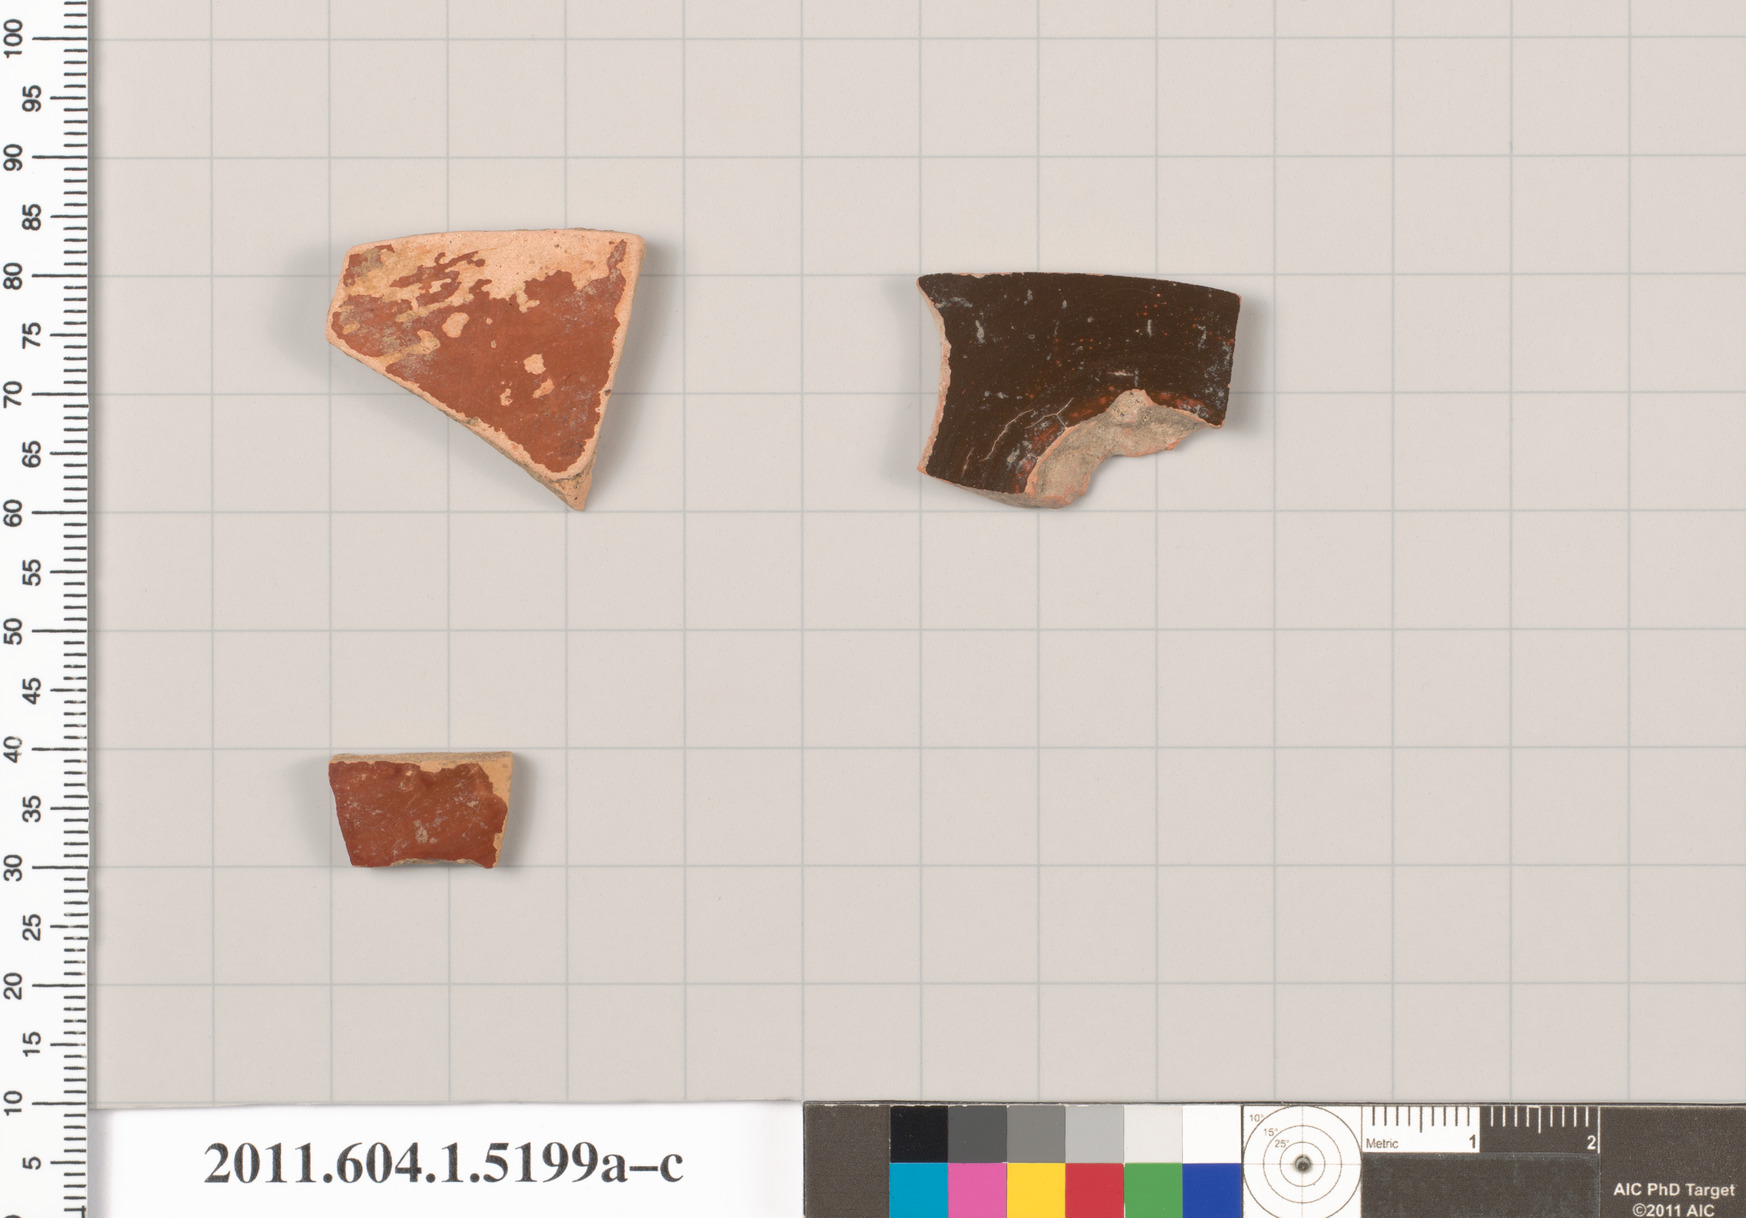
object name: kylix fragment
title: Terracotta fragments of kylikes (drinking cups)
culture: greek, attic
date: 500-451 BCE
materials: terracotta